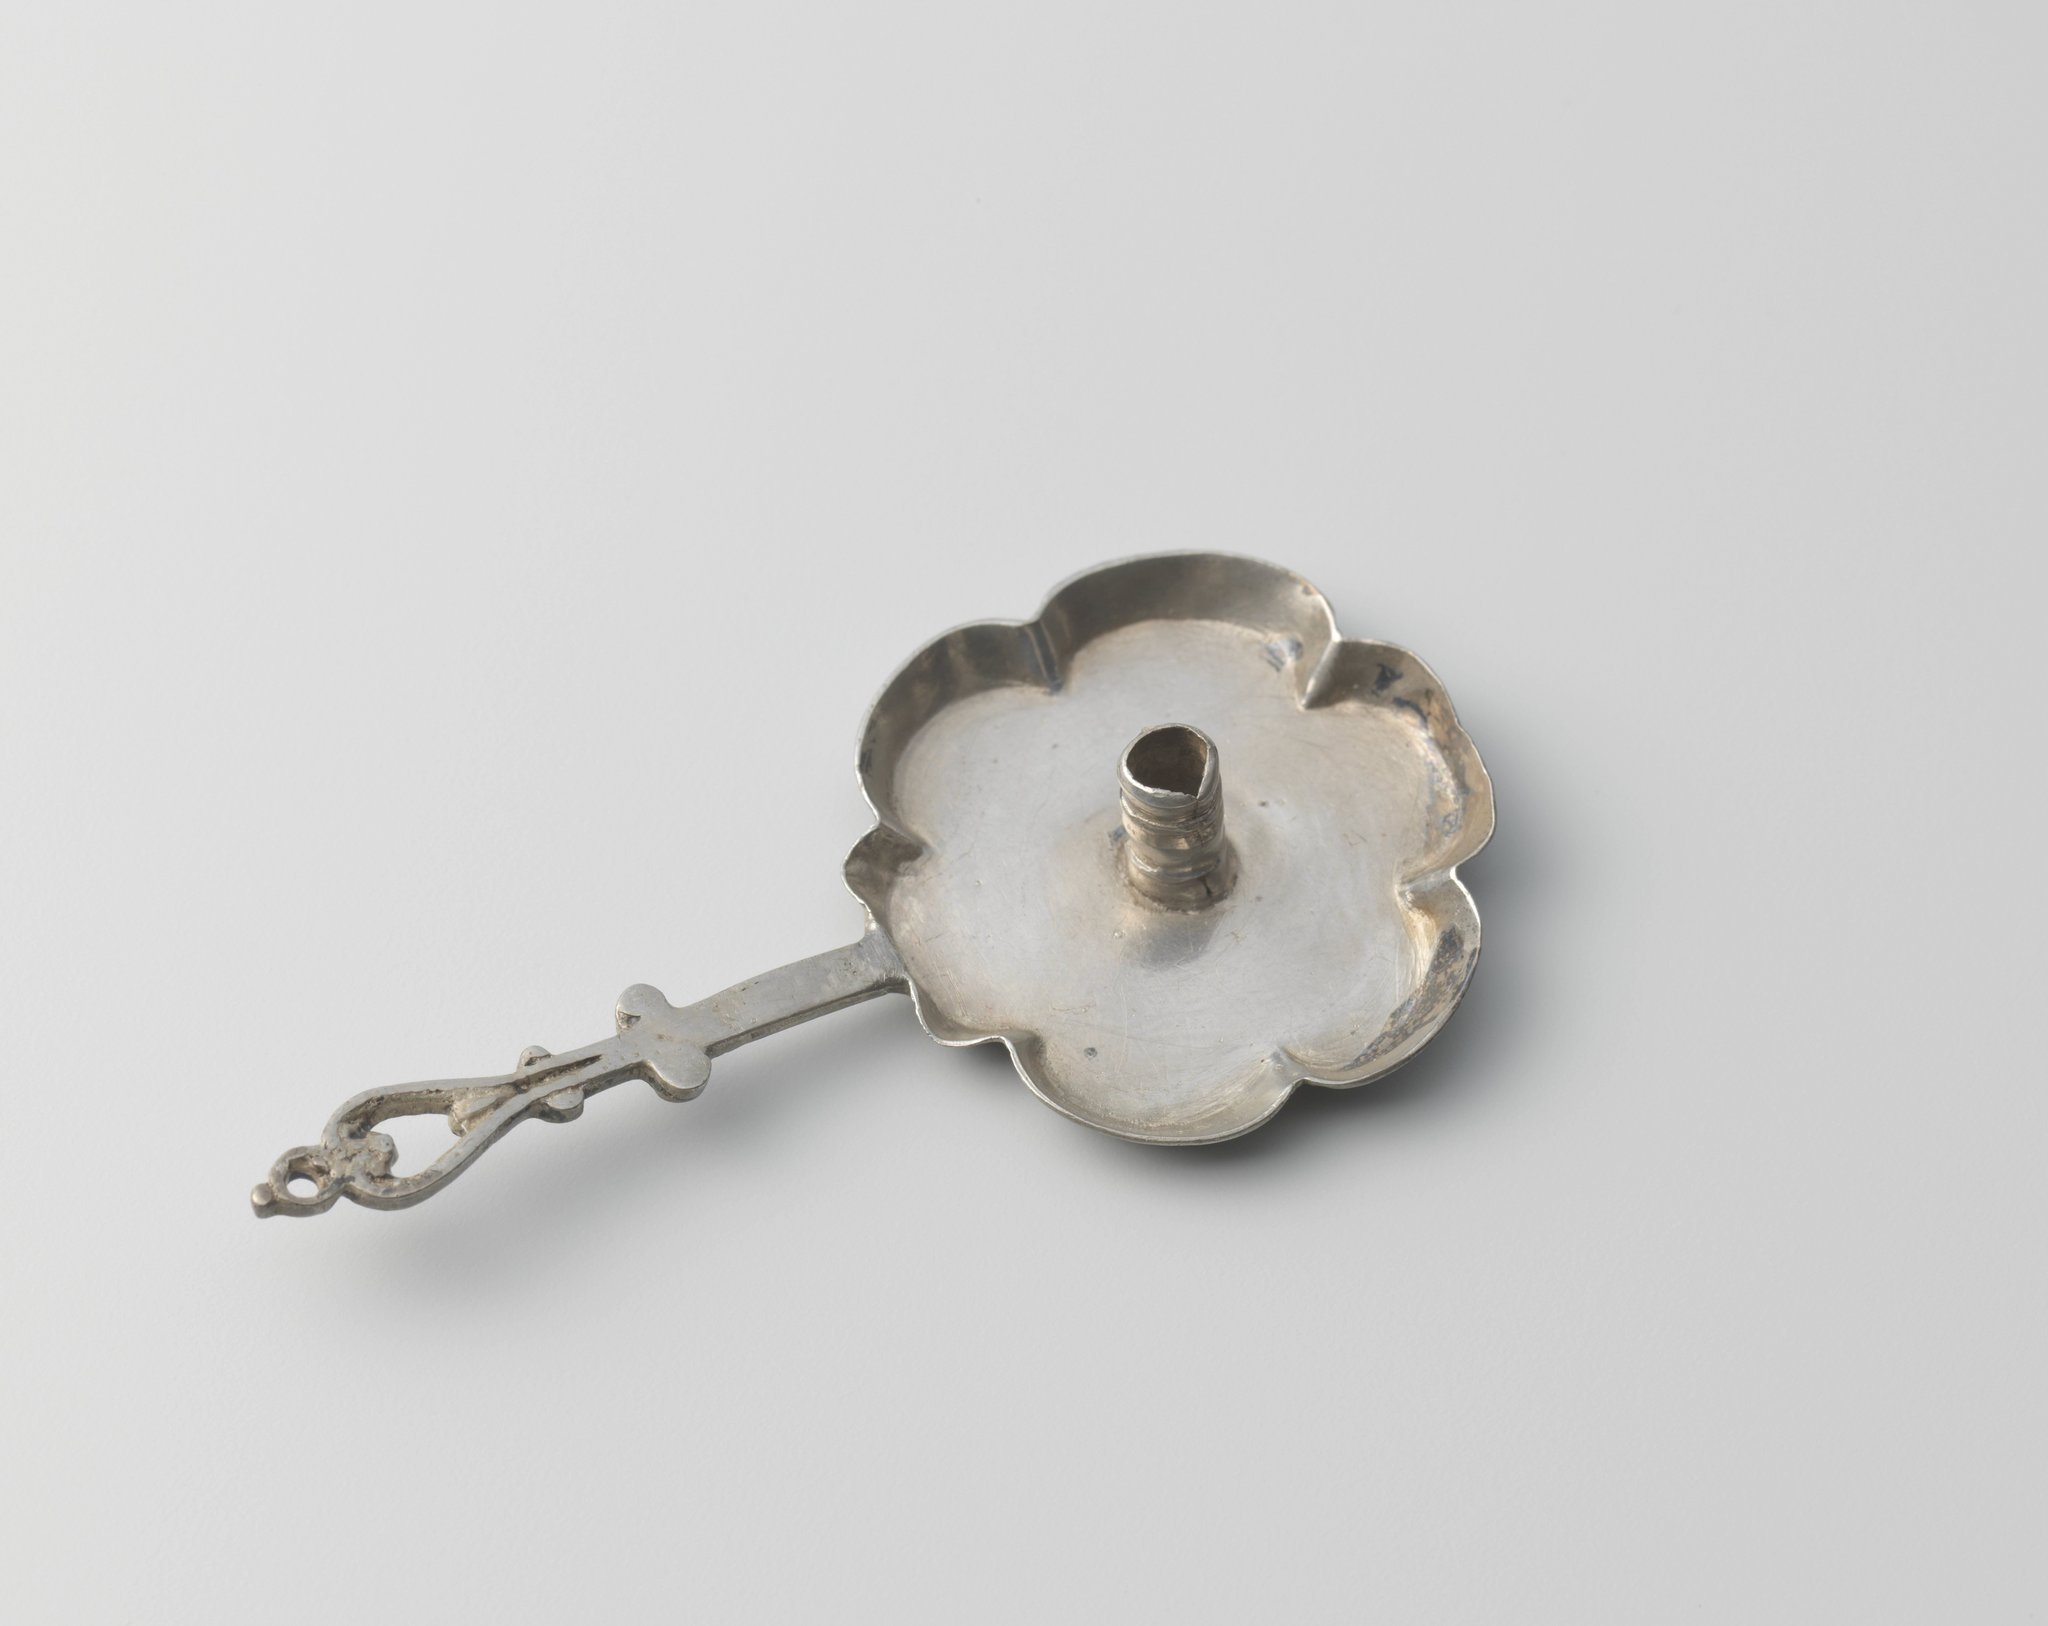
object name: miniature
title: Blaker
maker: Anonymous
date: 1675-1725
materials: silver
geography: netherlands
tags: candlestick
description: Blaker met zeslobbige, opstaande rand en een plat, aan het uiteinde opengewerkt handvat. Bij de blaker wordt een kaarsensnuiter bewaard. De blaker is gemerkt, maar de merken zijn onleesbaar.